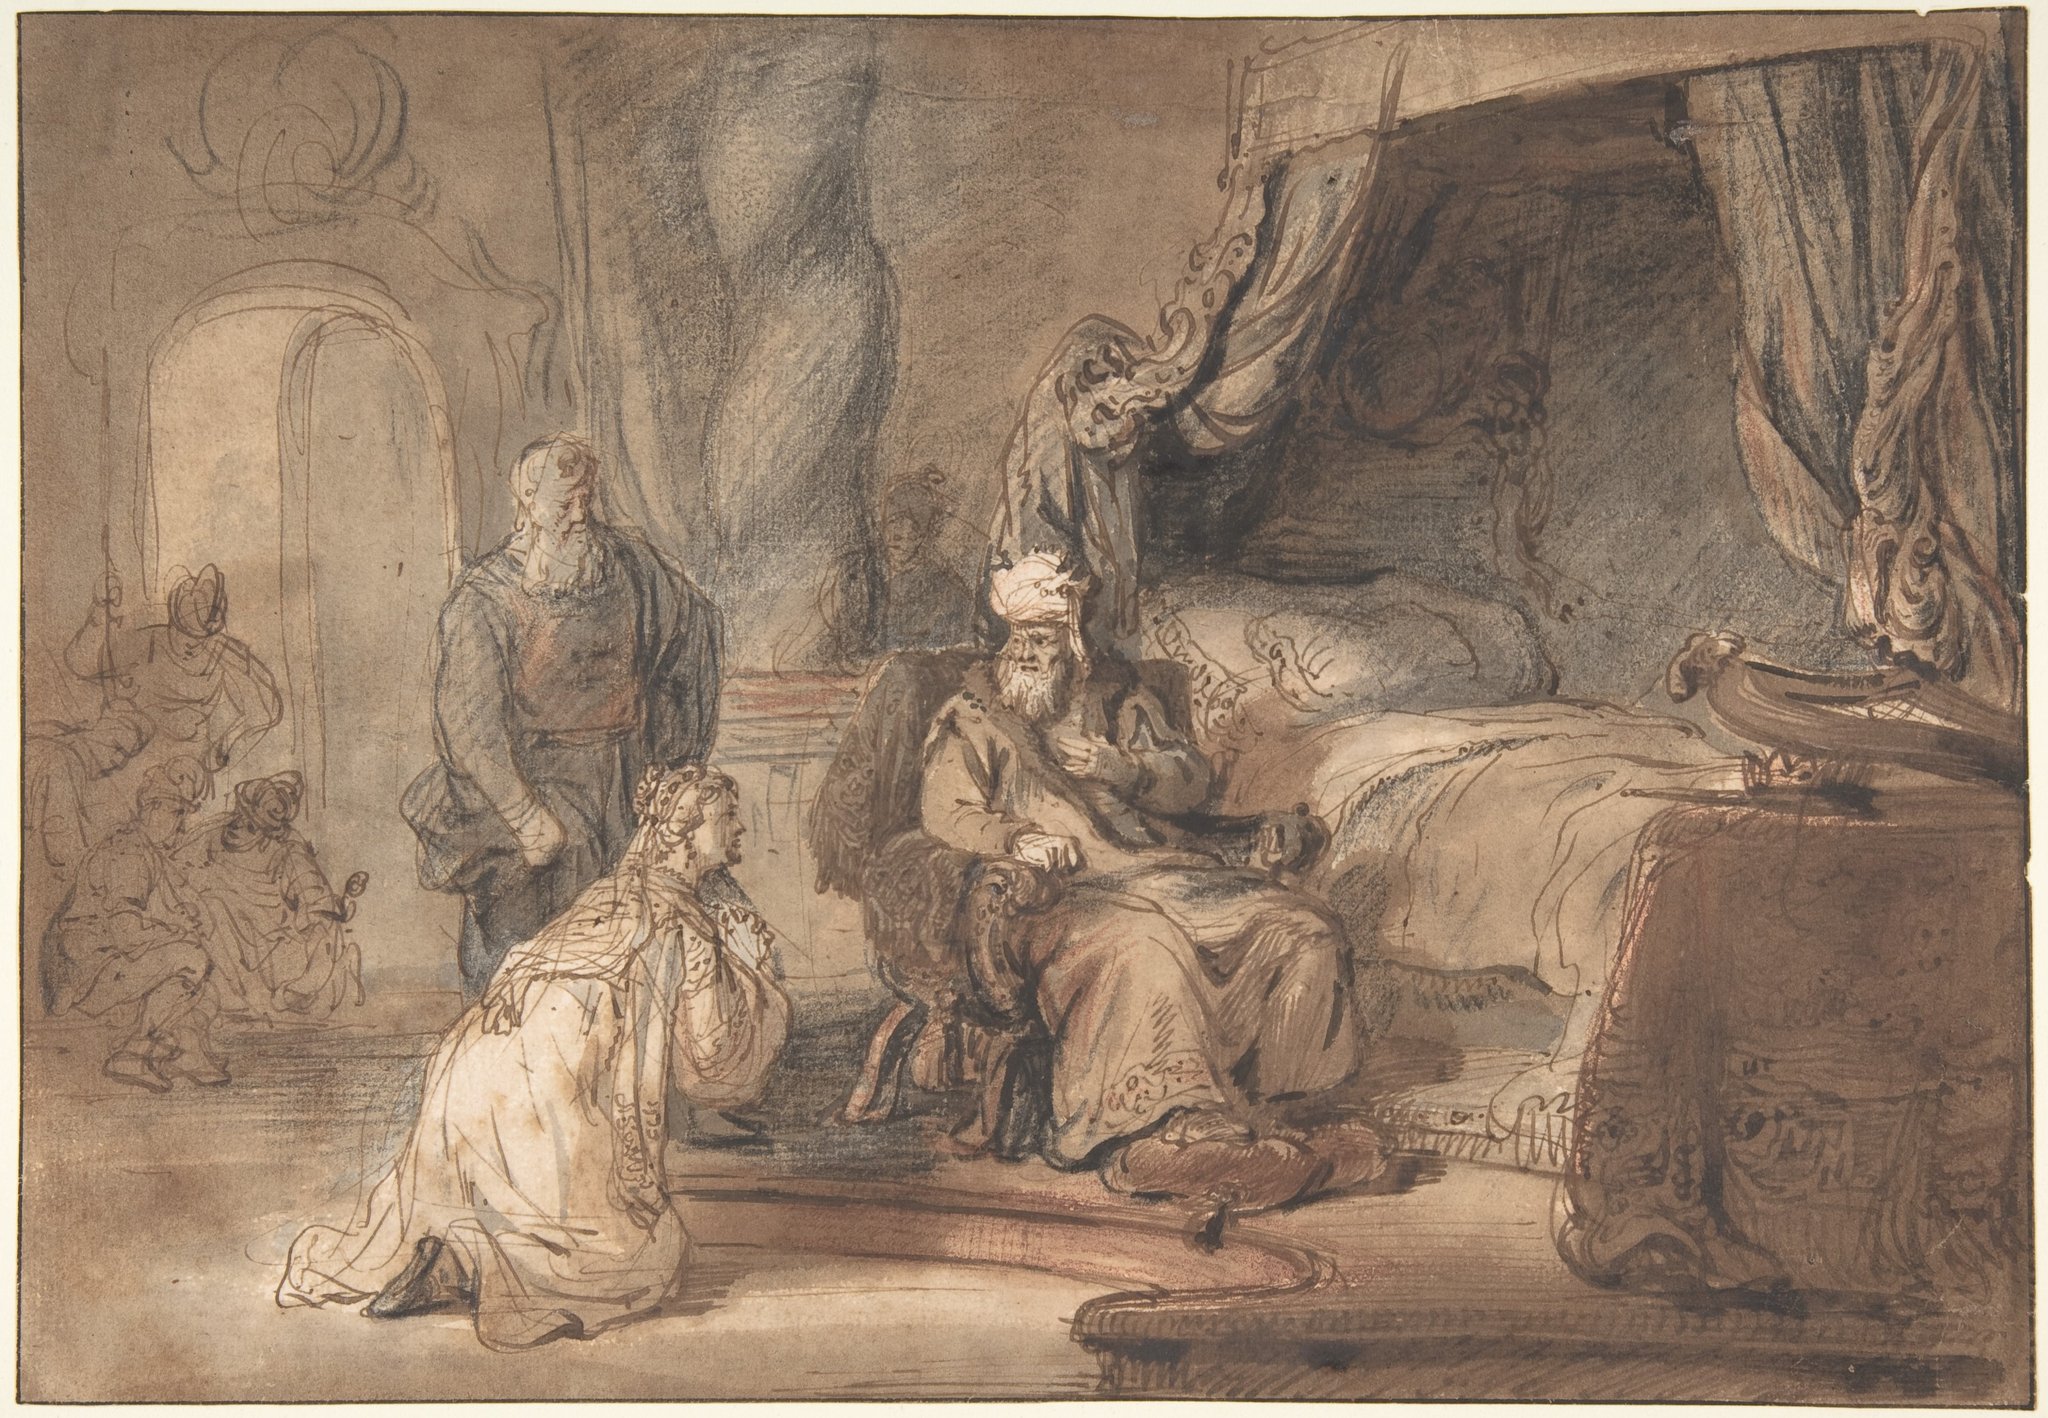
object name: drawing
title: David's Promise to Bathsheba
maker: gerbrand van den eeckhout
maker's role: artist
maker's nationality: dutch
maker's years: 1621-1674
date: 1642-1643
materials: chalk, ink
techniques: pen, wash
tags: men,bathsheba